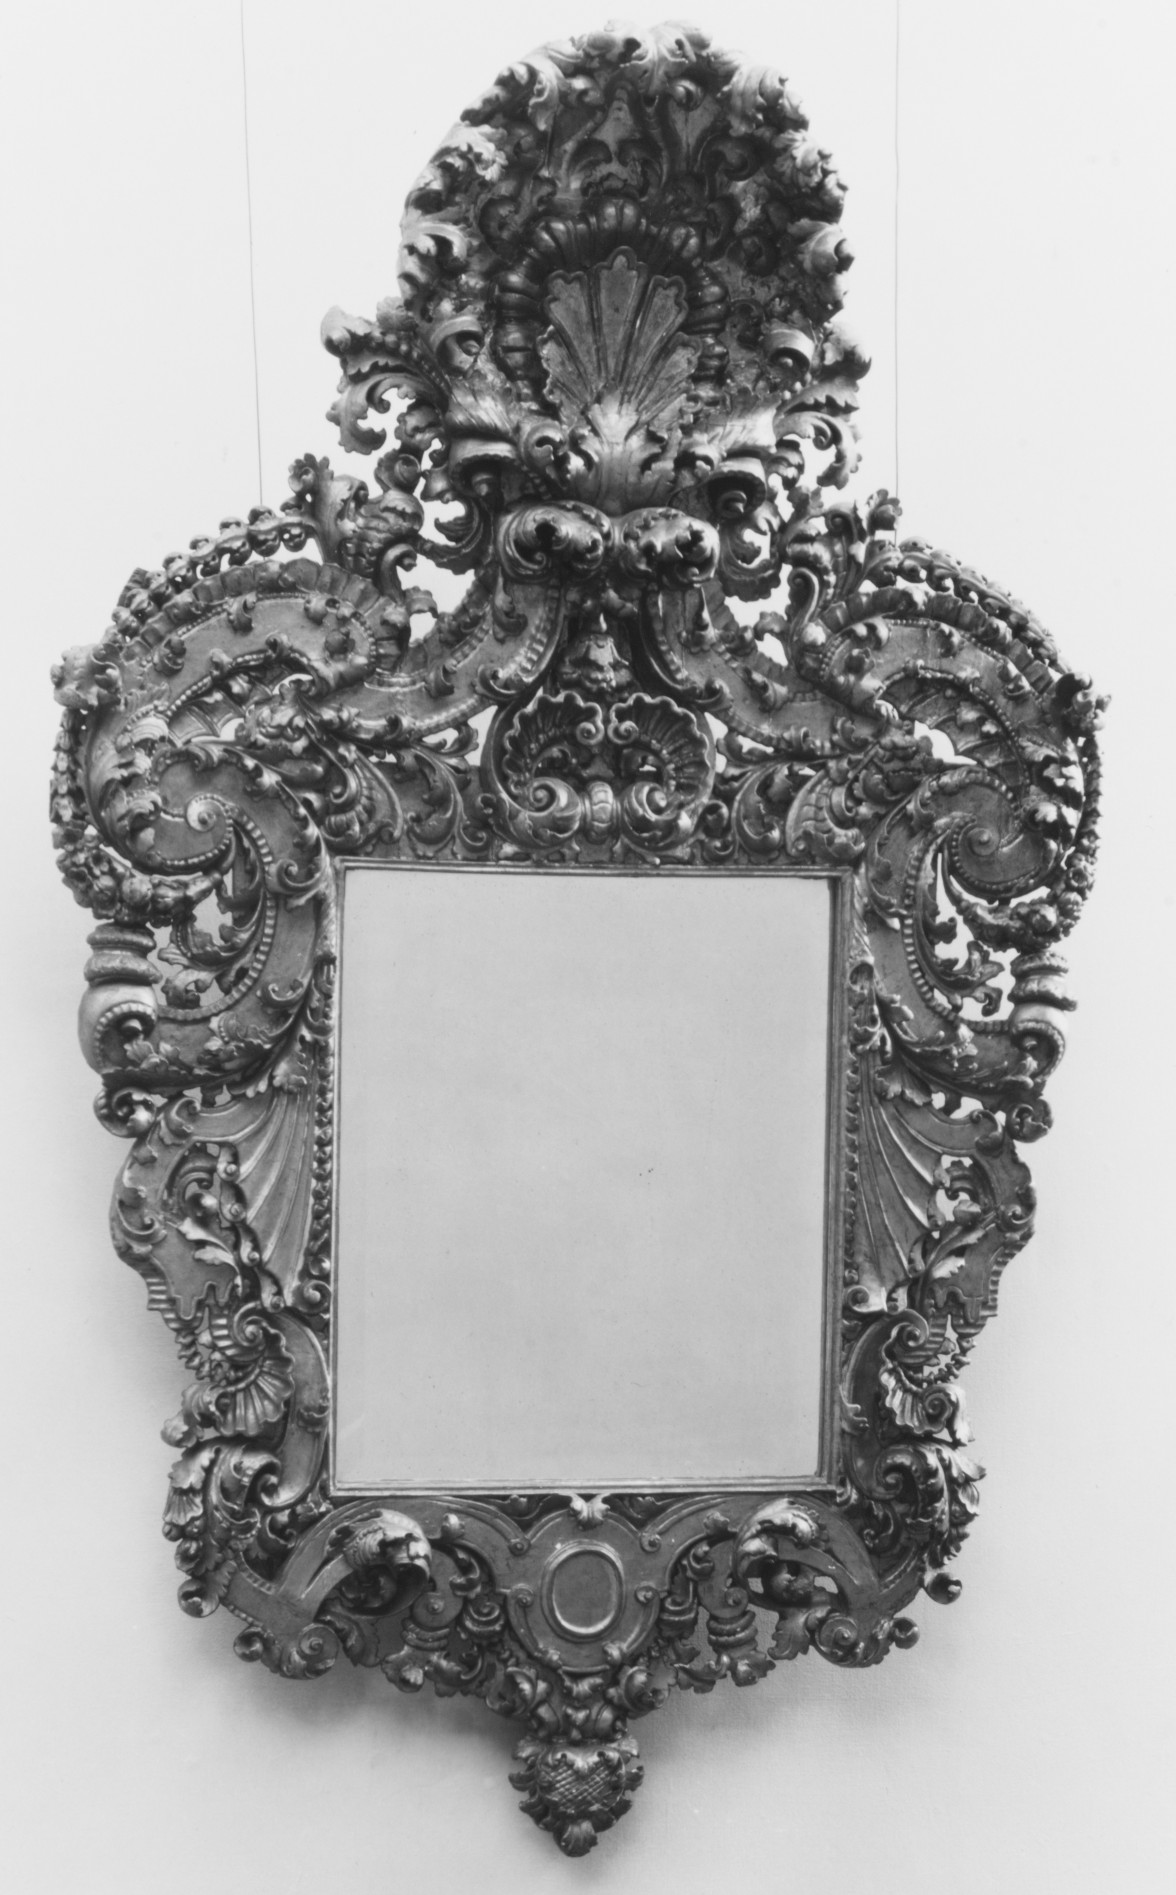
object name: mirror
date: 1667-1700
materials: wood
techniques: carving, gilding